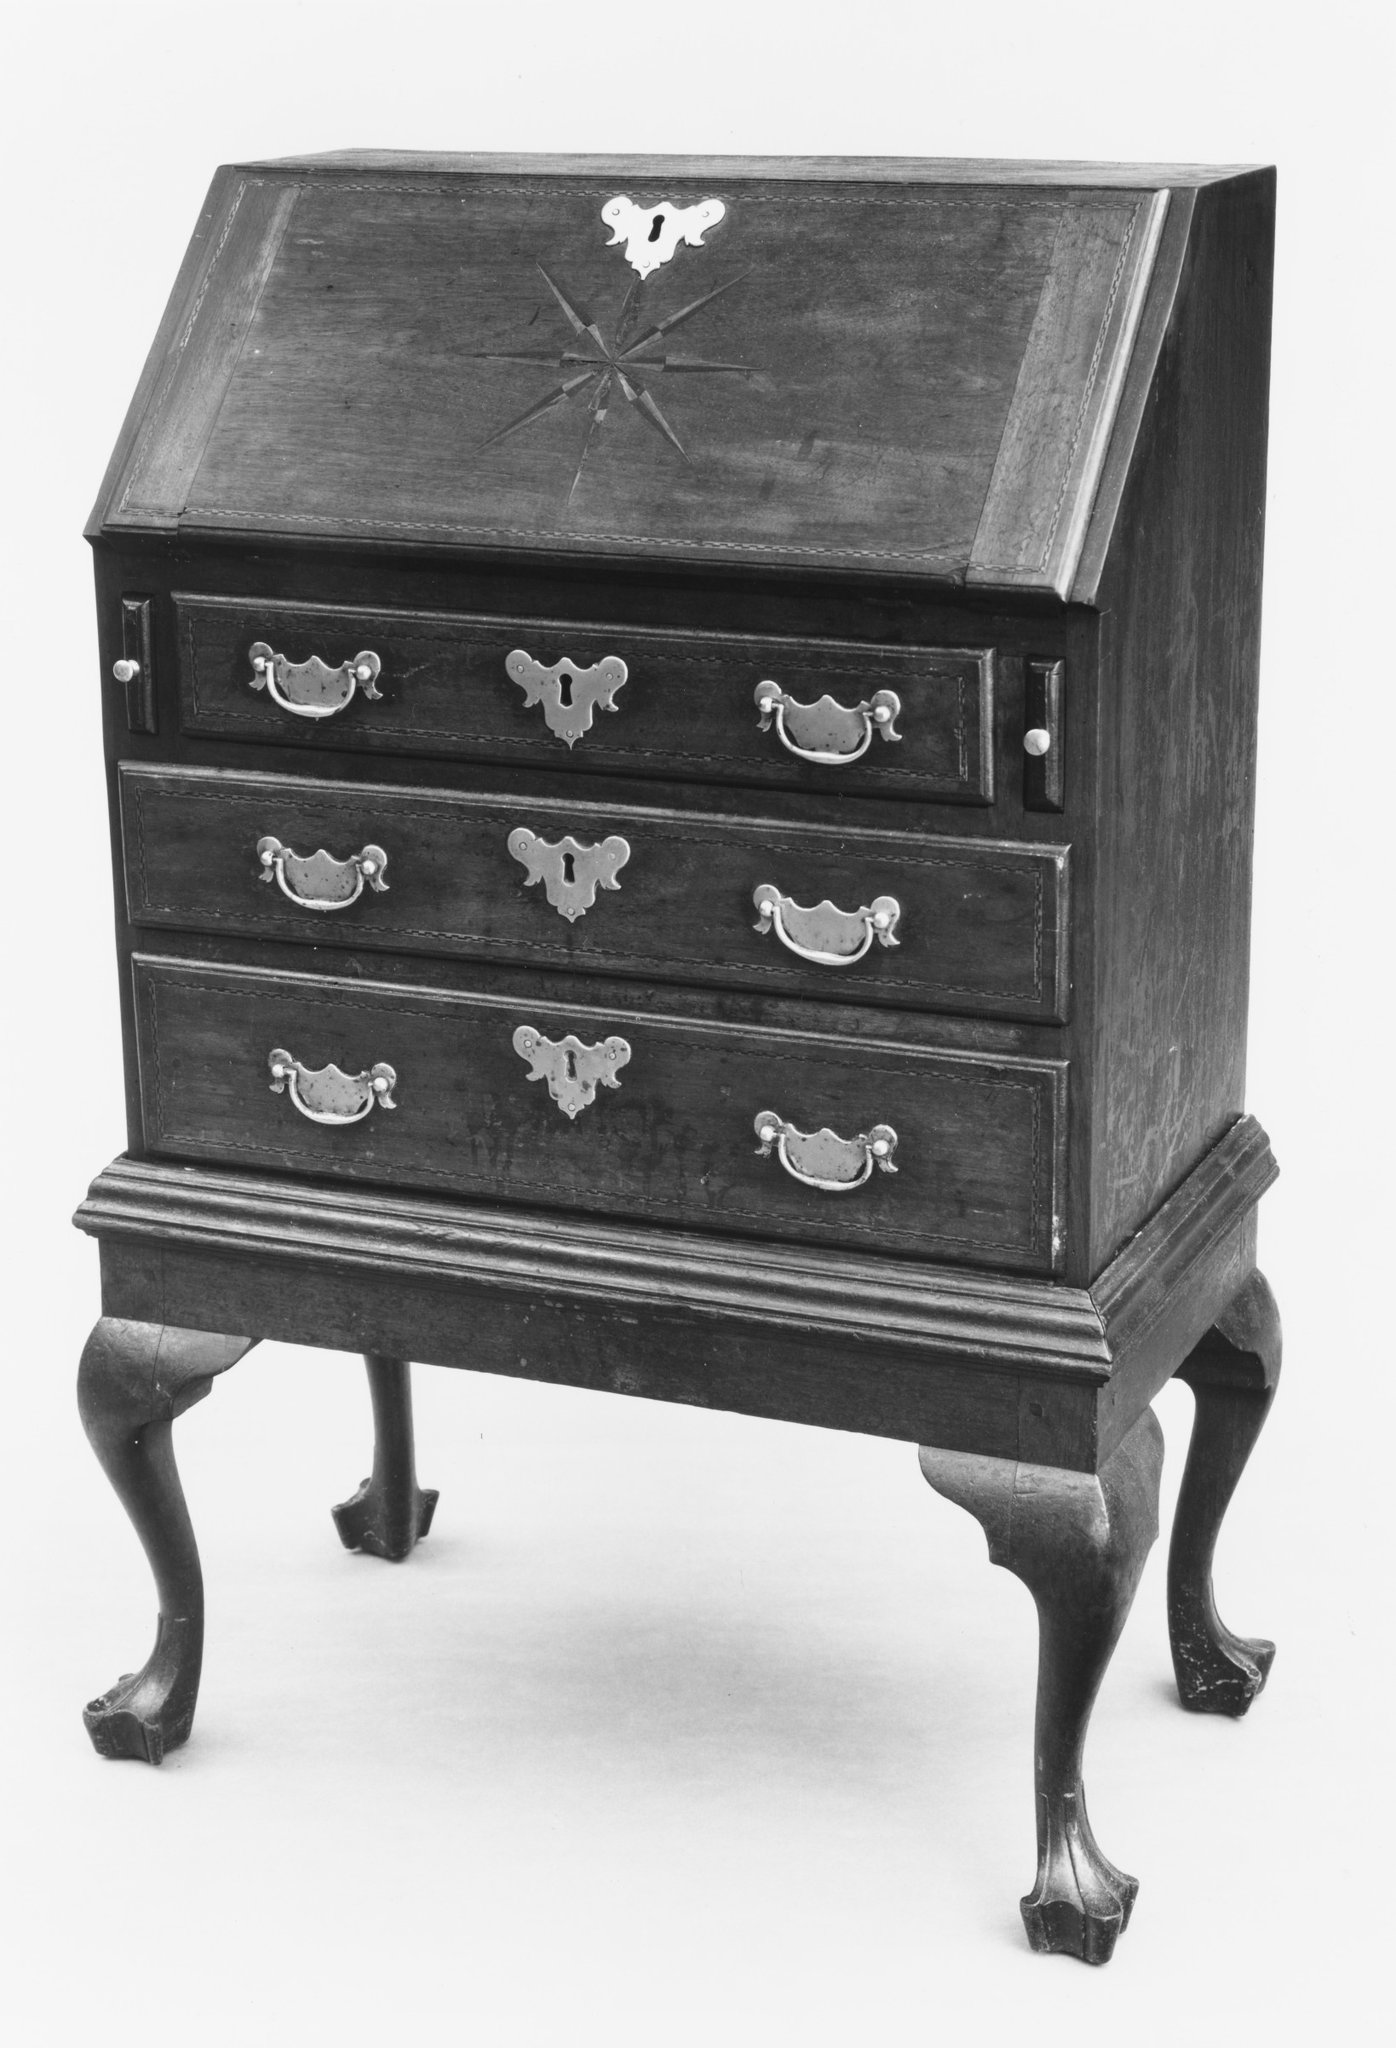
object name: desk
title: Child's Desk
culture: american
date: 1730-1760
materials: wood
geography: united states